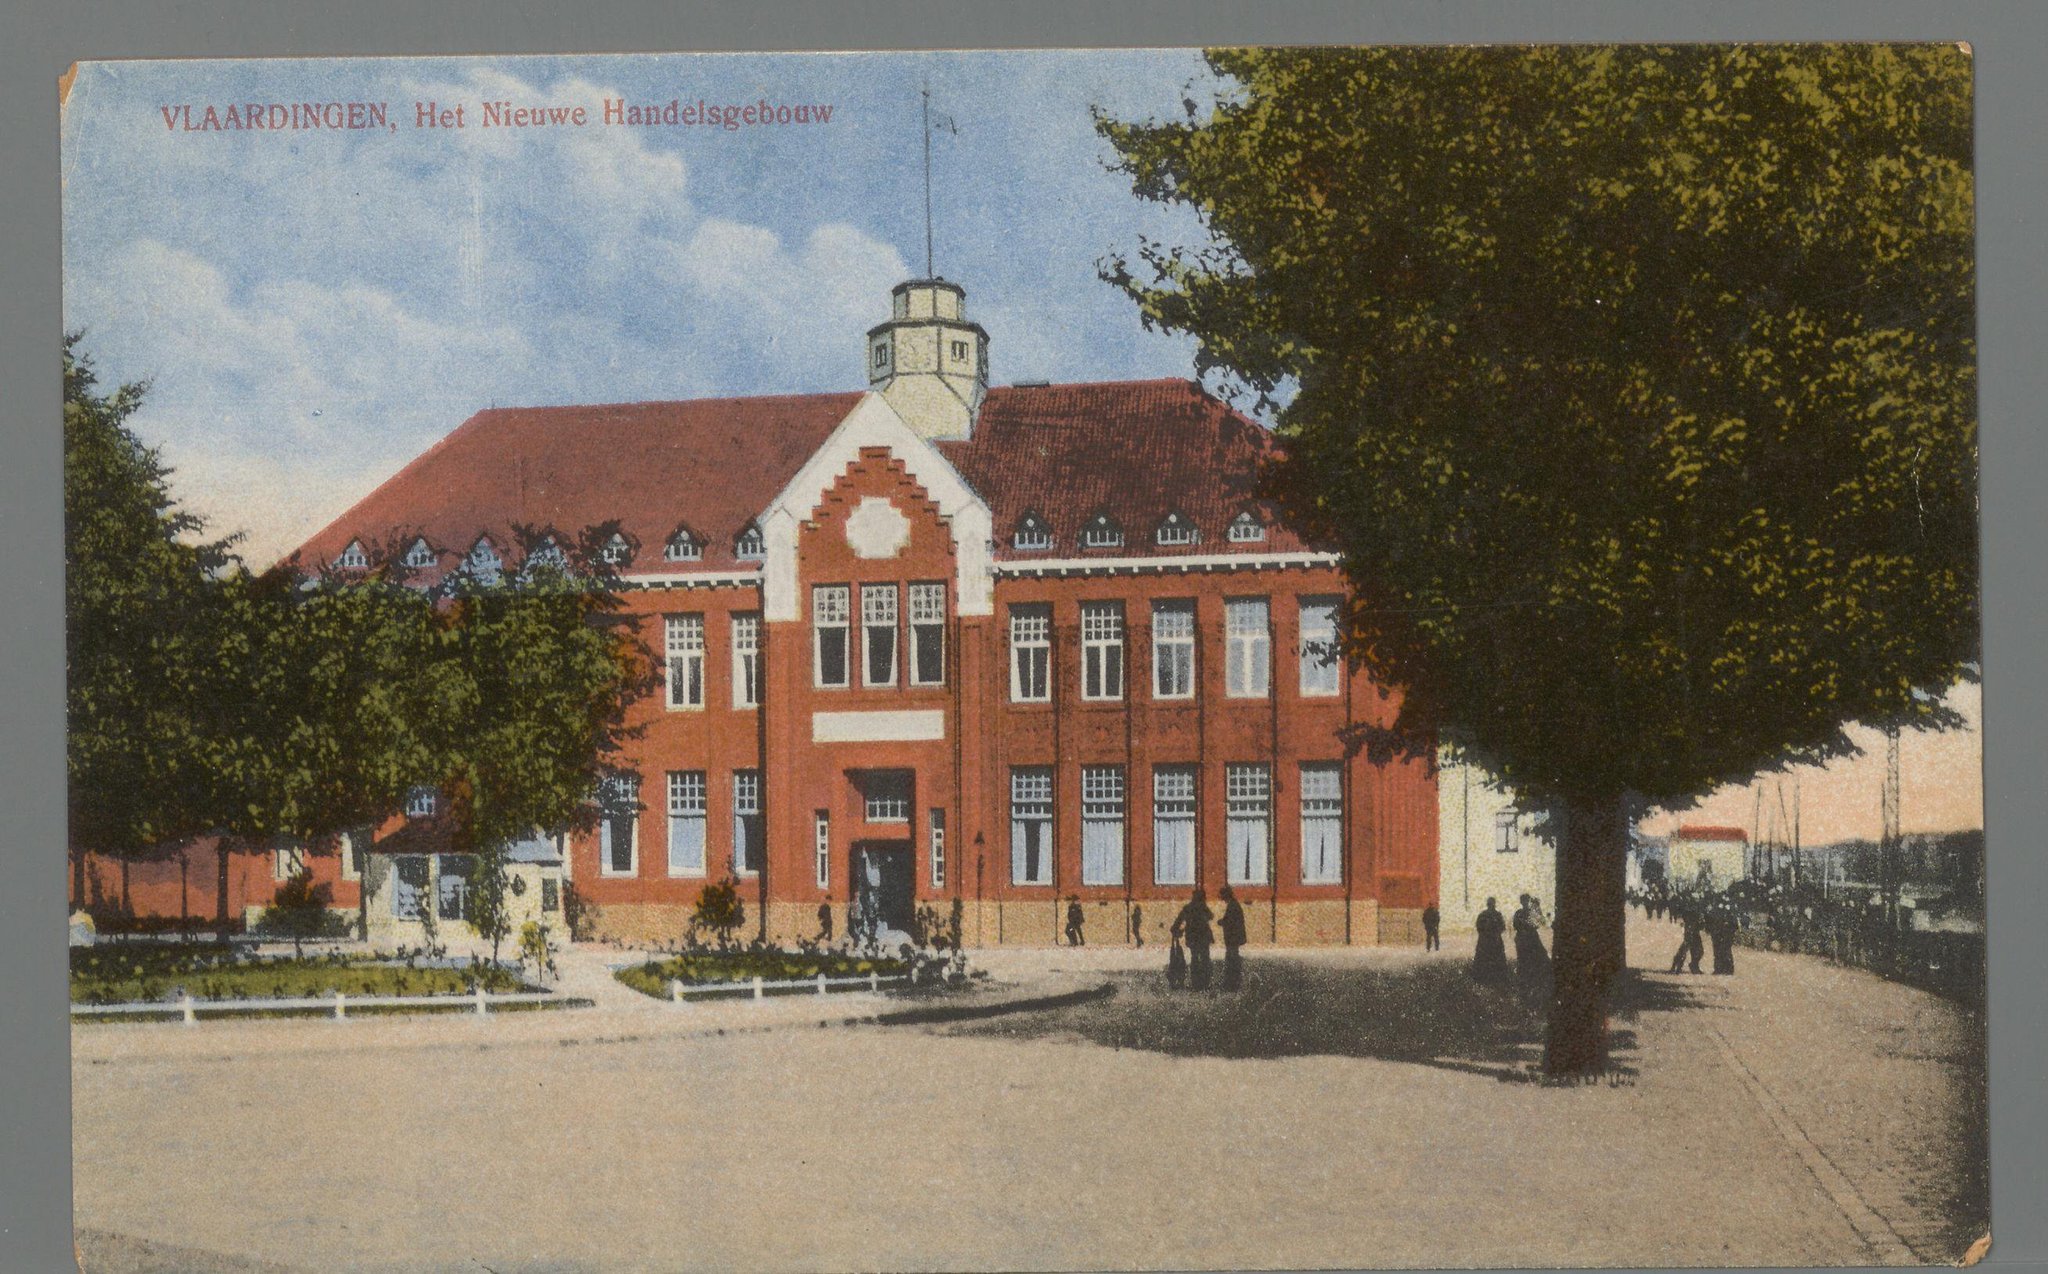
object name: photomechanical print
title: Vlaardingen, het Nieuwe Handelsgebouw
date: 1905-1930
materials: cardboard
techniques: photograph, lithograph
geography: vlaardingen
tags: organization of trade and finance